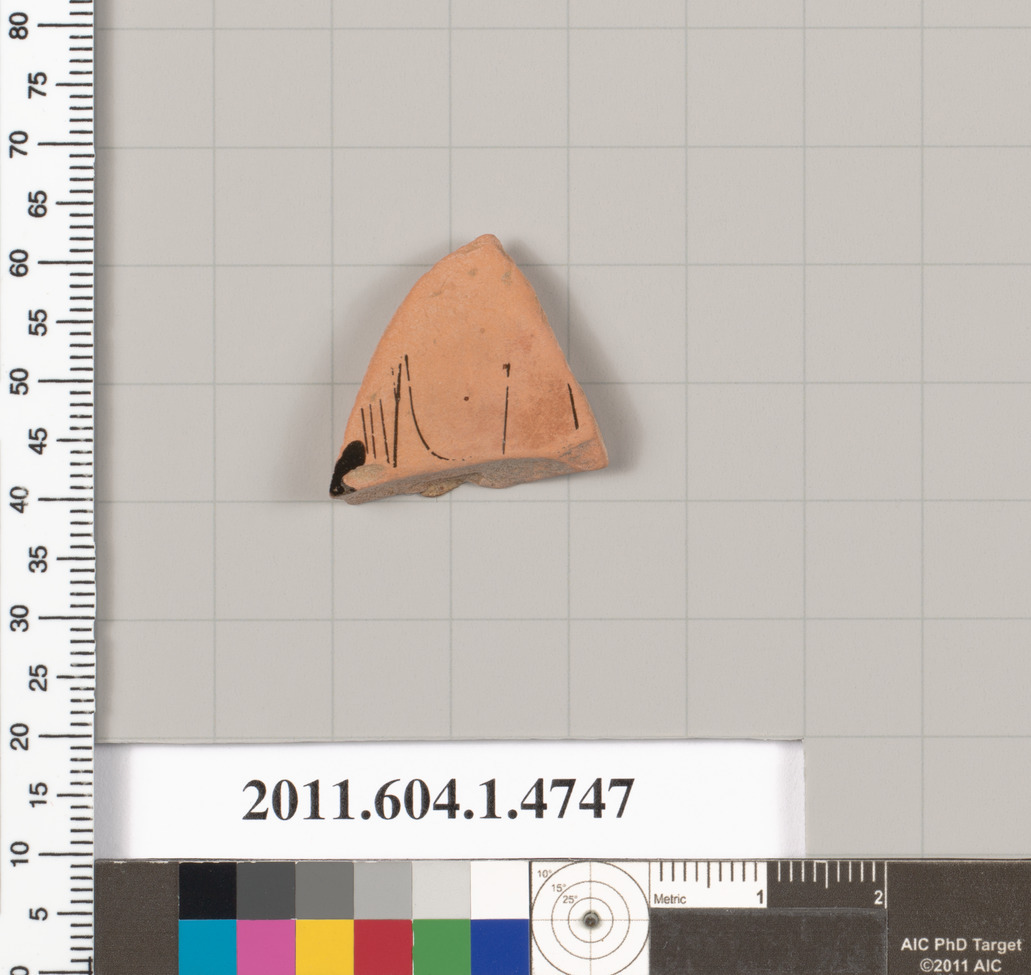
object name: kylix fragment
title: Terracotta fragment of a kylix (drinking cup)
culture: greek, attic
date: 460-450 BCE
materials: terracotta